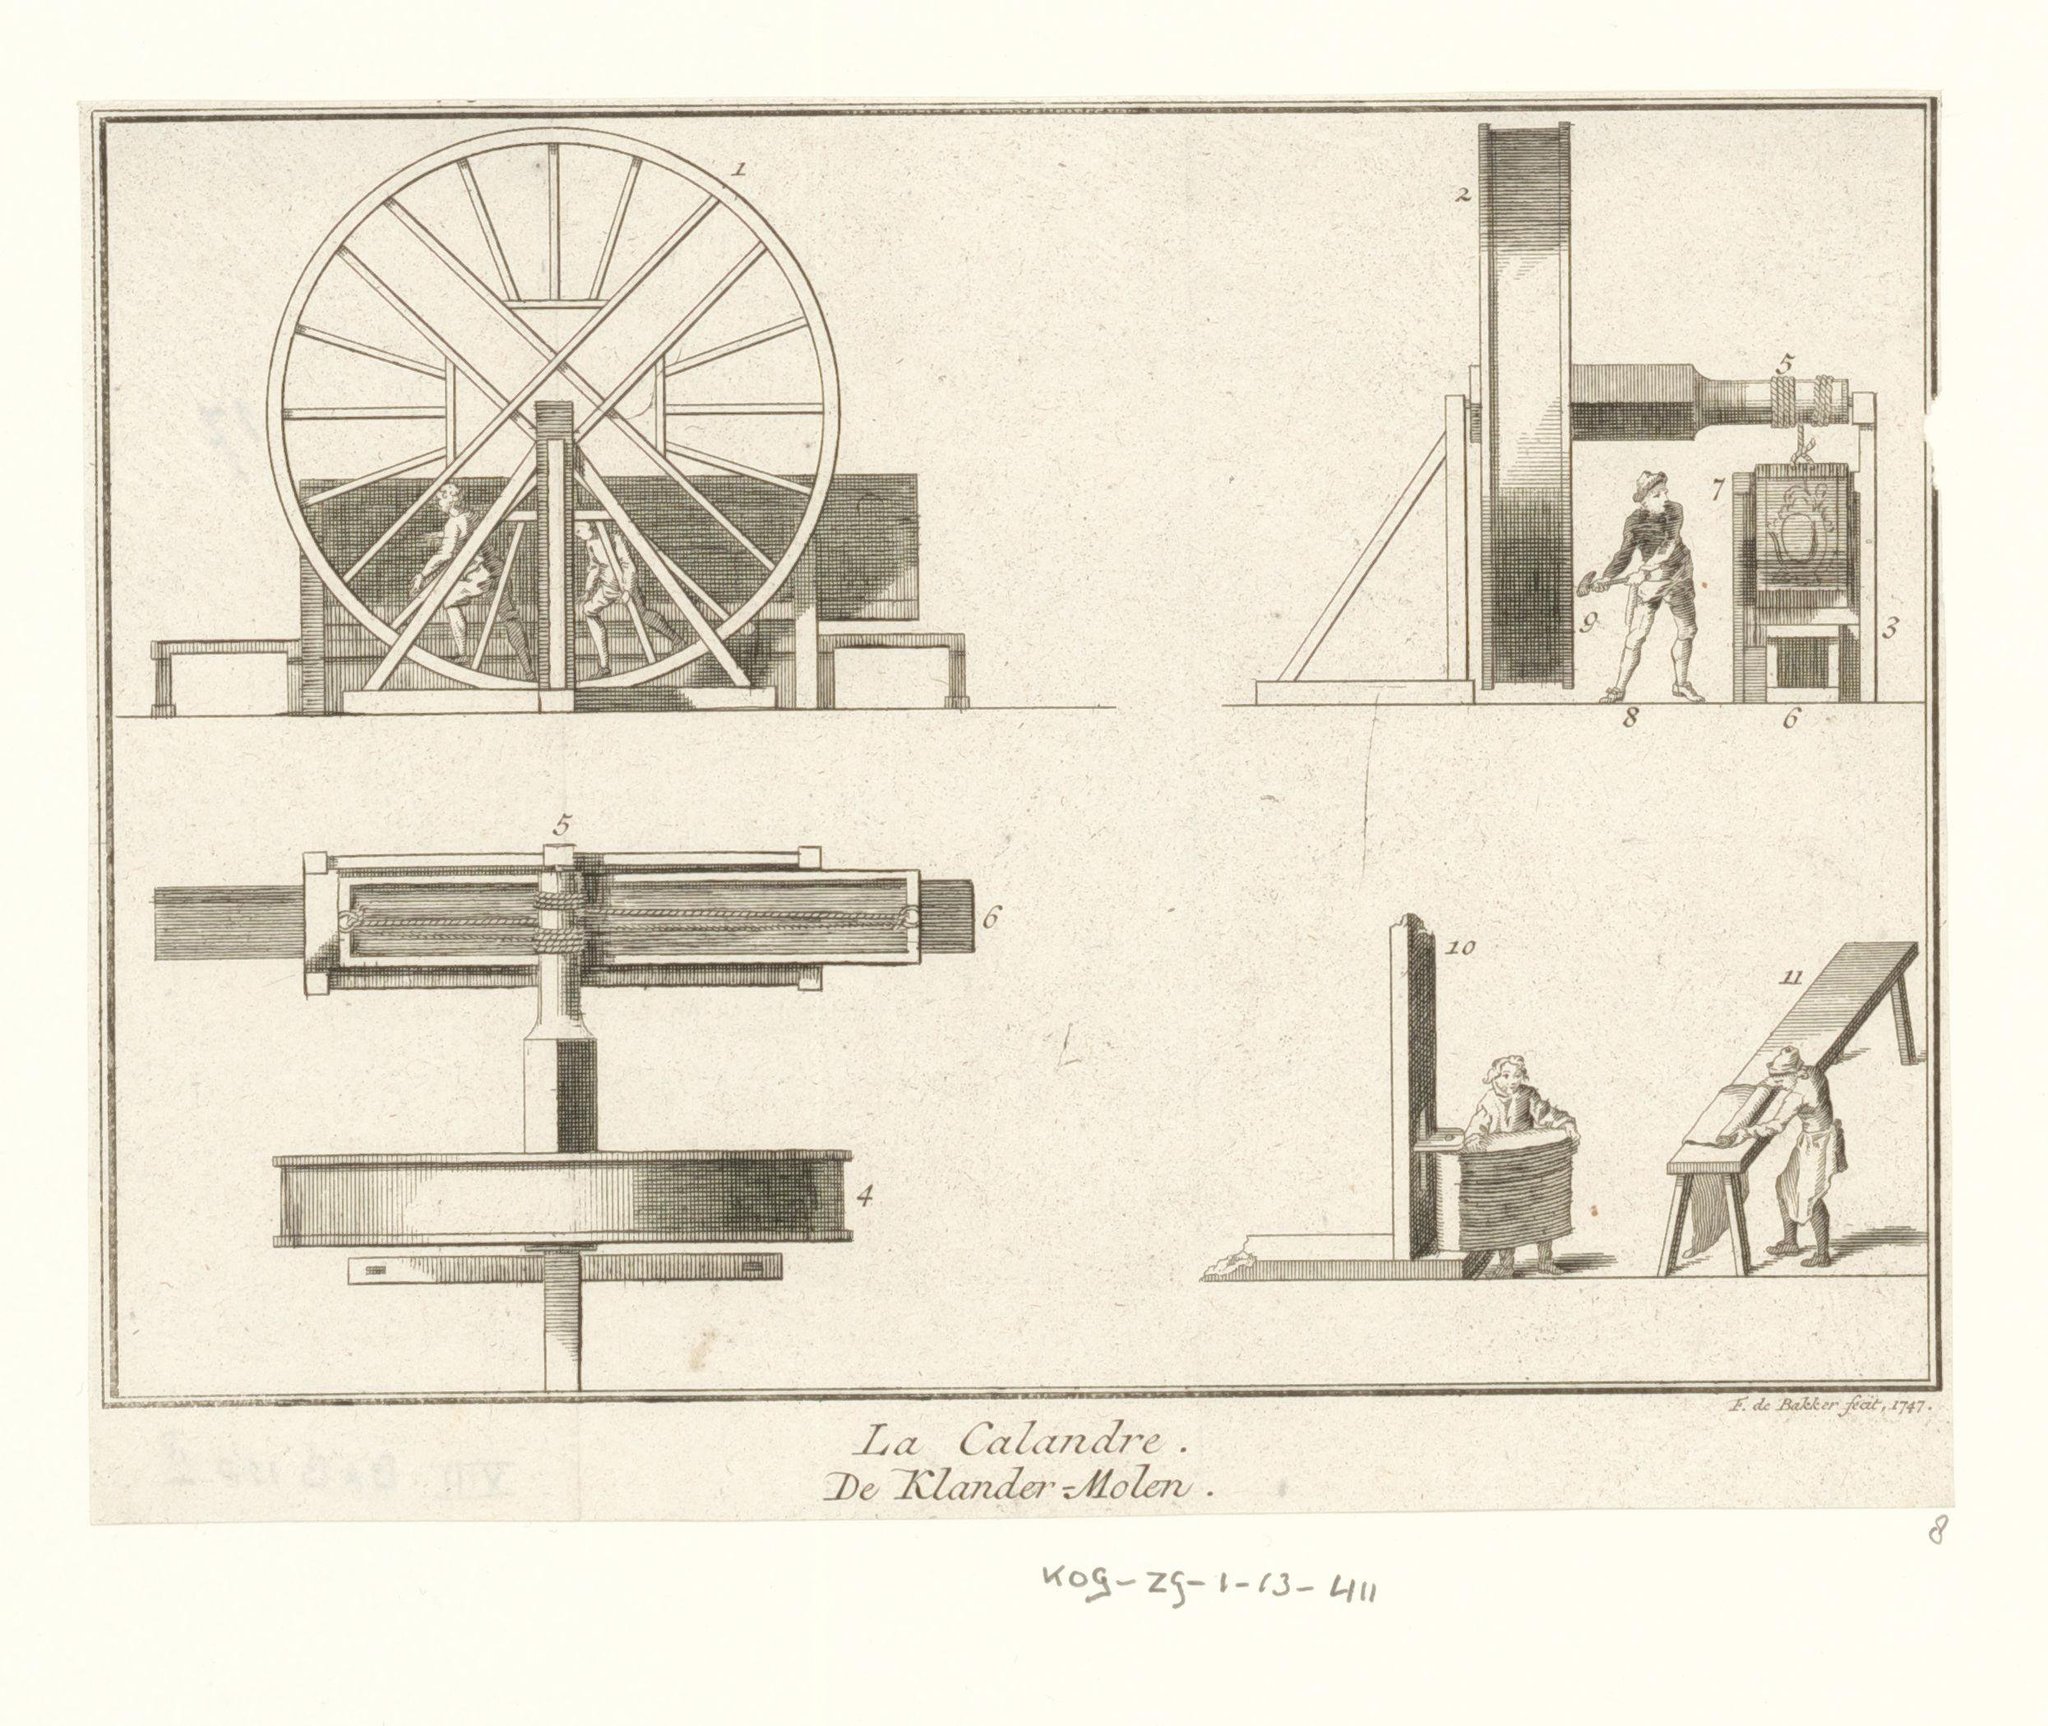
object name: print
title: La Calandre / De Klander-Molen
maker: frans de bakker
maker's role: print maker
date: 1747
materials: paper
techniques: engraving, etching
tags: machines; parts of machines; tools and appliances, textile industry and clothing industry, textile fabric, cloth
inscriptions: stamp, collector's mark: Lugt 1641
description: Vier voorstellingen van de klandermolen en de bediening. In de kalanderij of klandermolen werden geweven stoffen, papier en leer glad gemaakt. Onderaan een schaalmeter. Onderwerpsrubrieken binnen de Atlas Zeden en Gewoonten: Handel, Nijverheid en verkeer, Beroep en bedrijf, Mannelijk, Wevers.